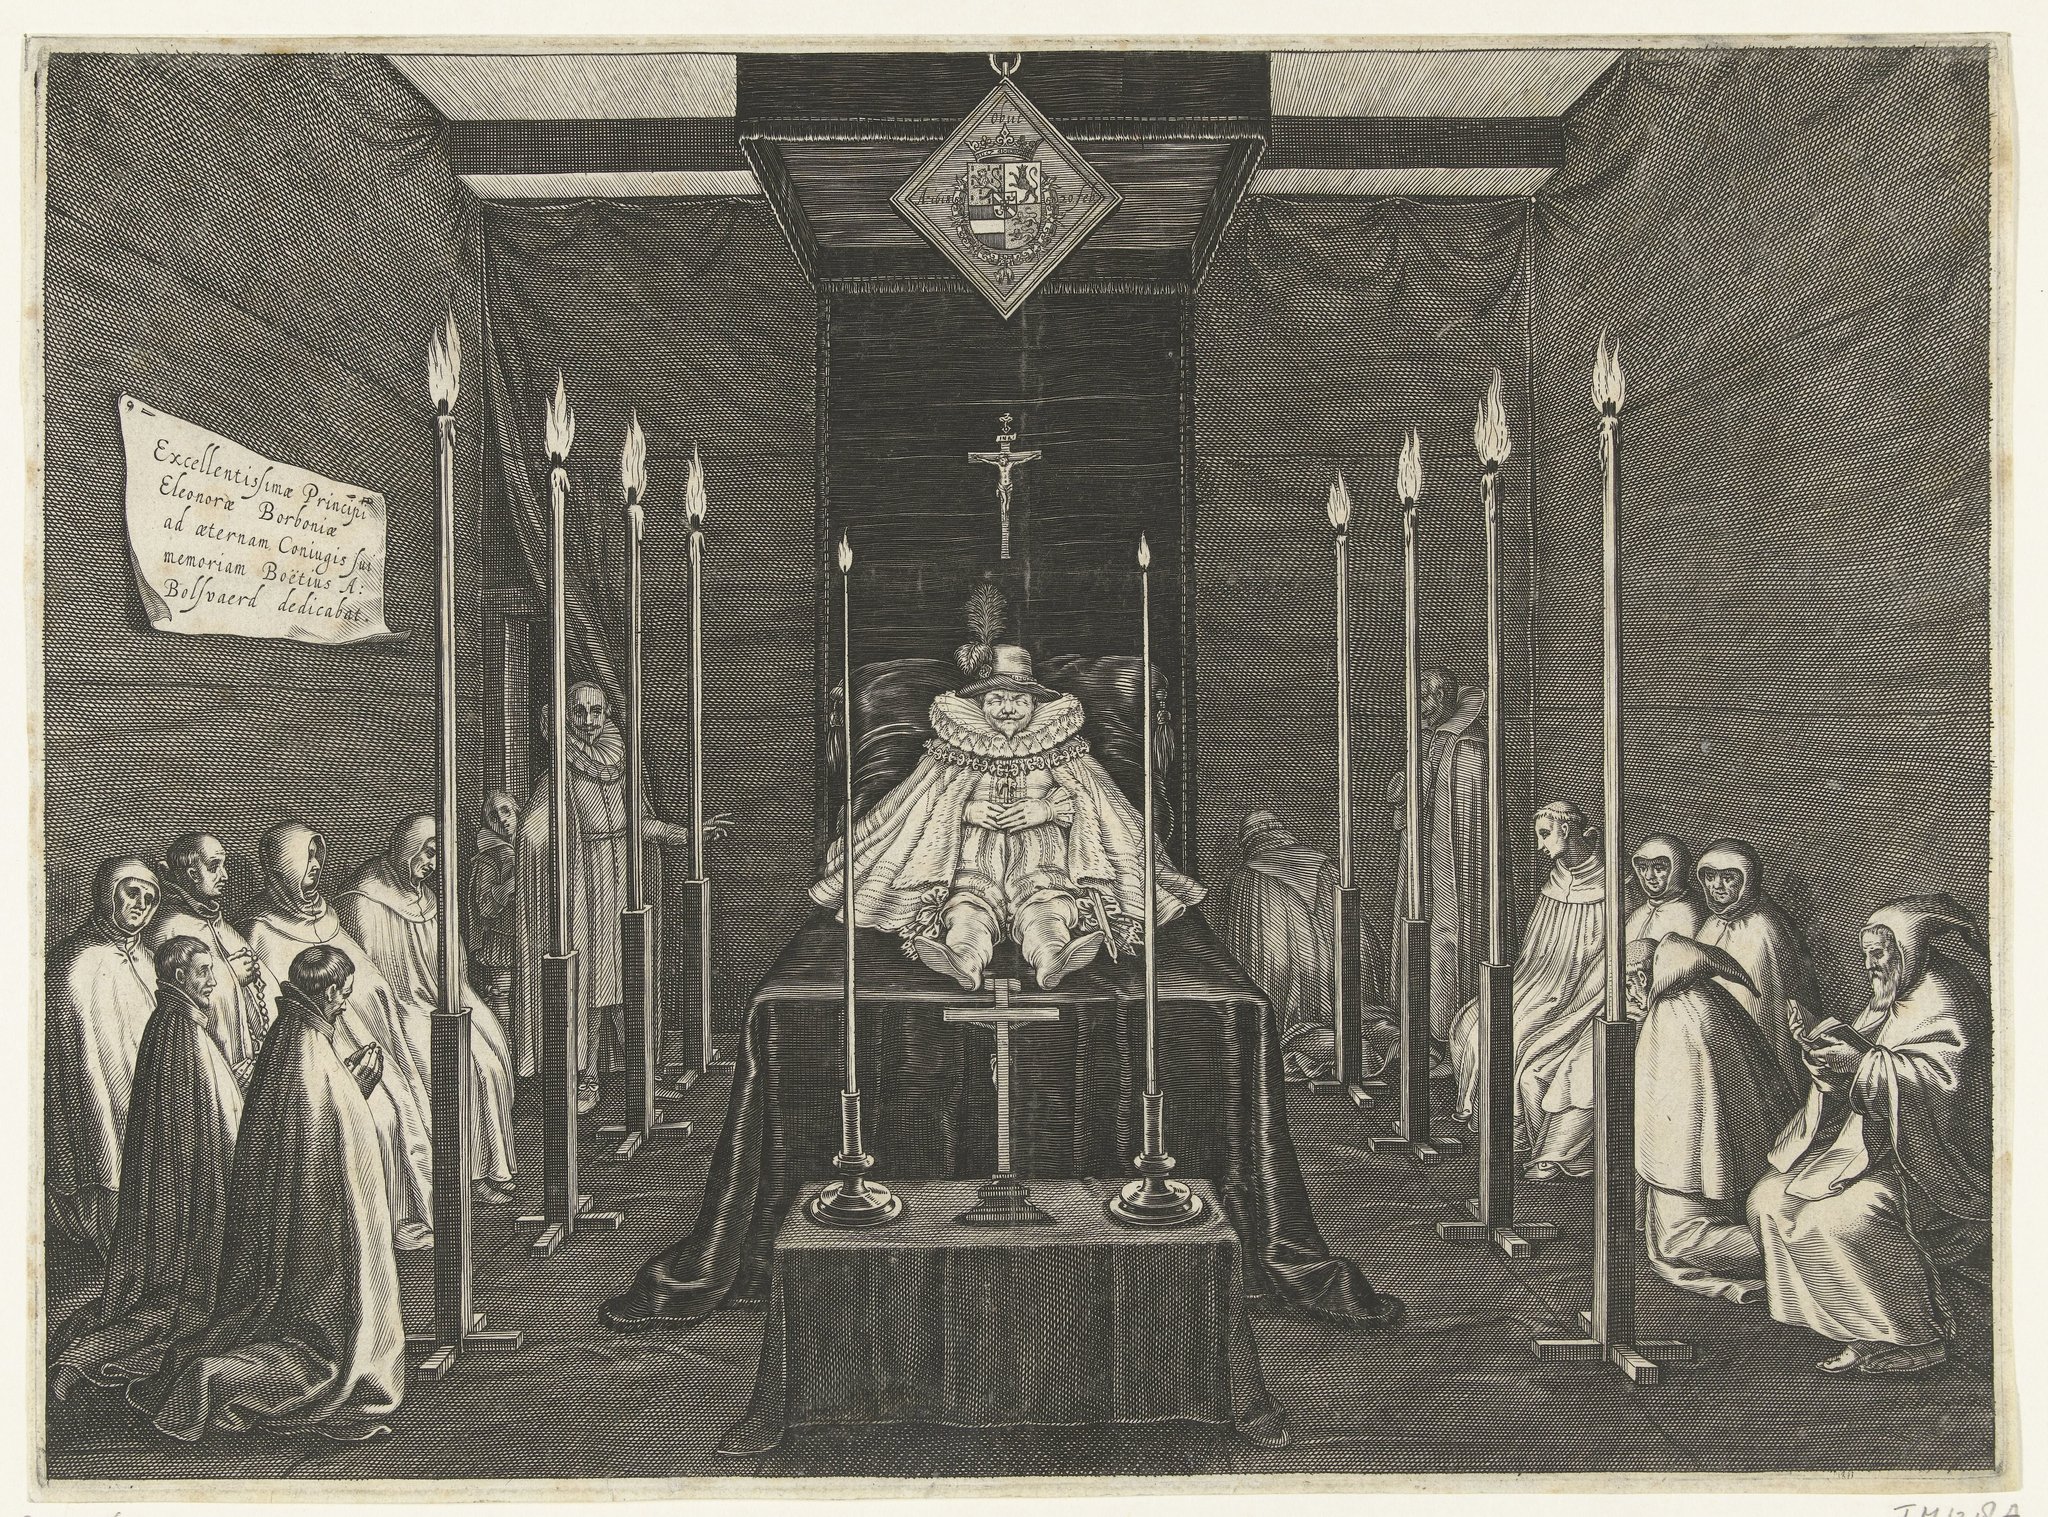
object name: print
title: Praalbed van prins Filips Willem, 1618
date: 1618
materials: paper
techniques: engraving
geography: low countries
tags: buren, bruges, filips willem (prins van oranje), lying in state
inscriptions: collector's mark: Lugt 151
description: Het praalbed van Filips Willem, prins van Oranje, opgericht op 8 maart 1618. De prins overleed te Brussel op 20 februari 1618. De prins ligt in galakleding opgebaard op een bed. Hieromheen brandende kaarsen en knielende en biddende monniken. Linksachter betreedt een man vanachter een gordijn de ruimte. Links aan de wand hangt de opdracht van Boëtius à Bolswert aan de prinses Eleonora van Bourbon, de weduwe van Filips Willem. Bij dit exemplaar ontbreekt het onderschrift dat volgens de beschrijving in Knuttel nr. 2496 bij de plaat behoort.